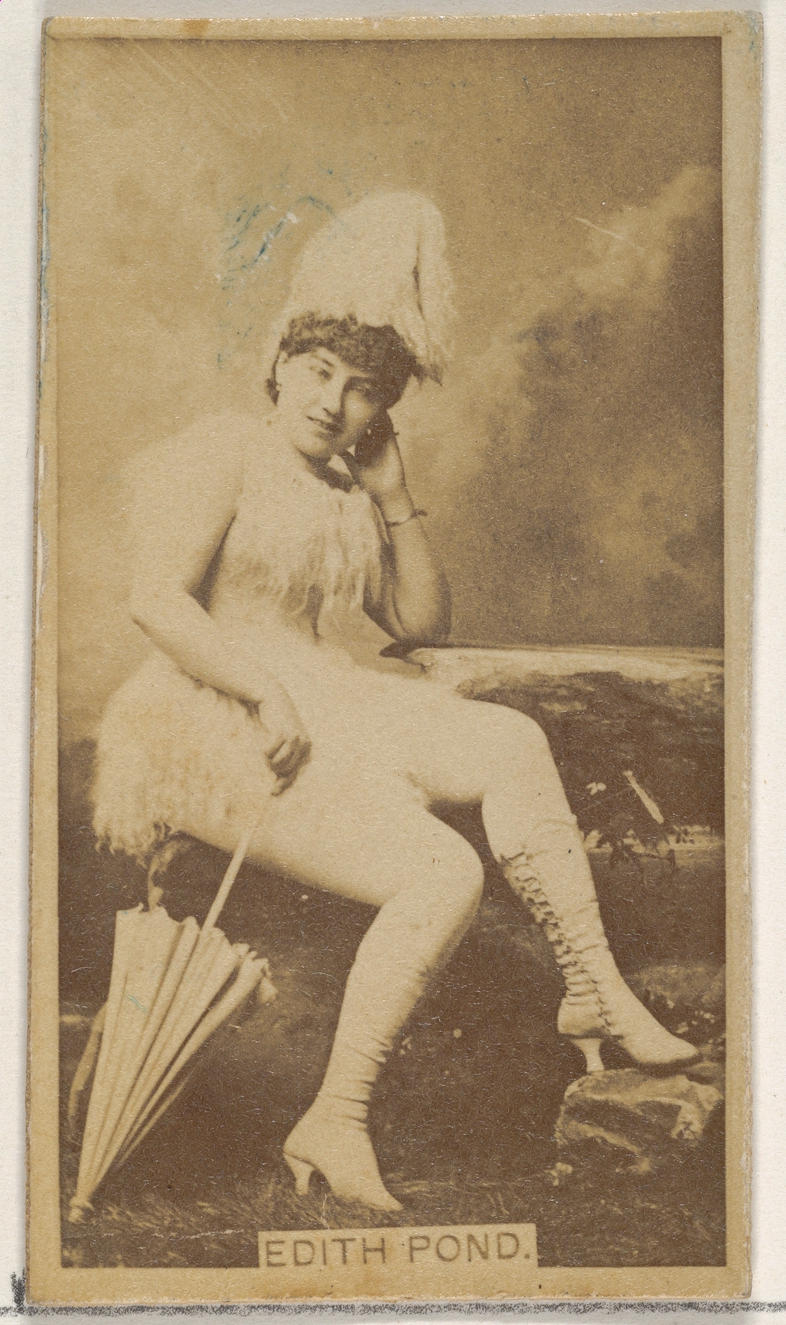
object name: photograph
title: Edith Pond, from the Actors and Actresses series (N45, Type 8) for Virginia Brights Cigarettes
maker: allen & ginter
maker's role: publisher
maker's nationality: american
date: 1888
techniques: albumen silver print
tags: portraits,women,actresses